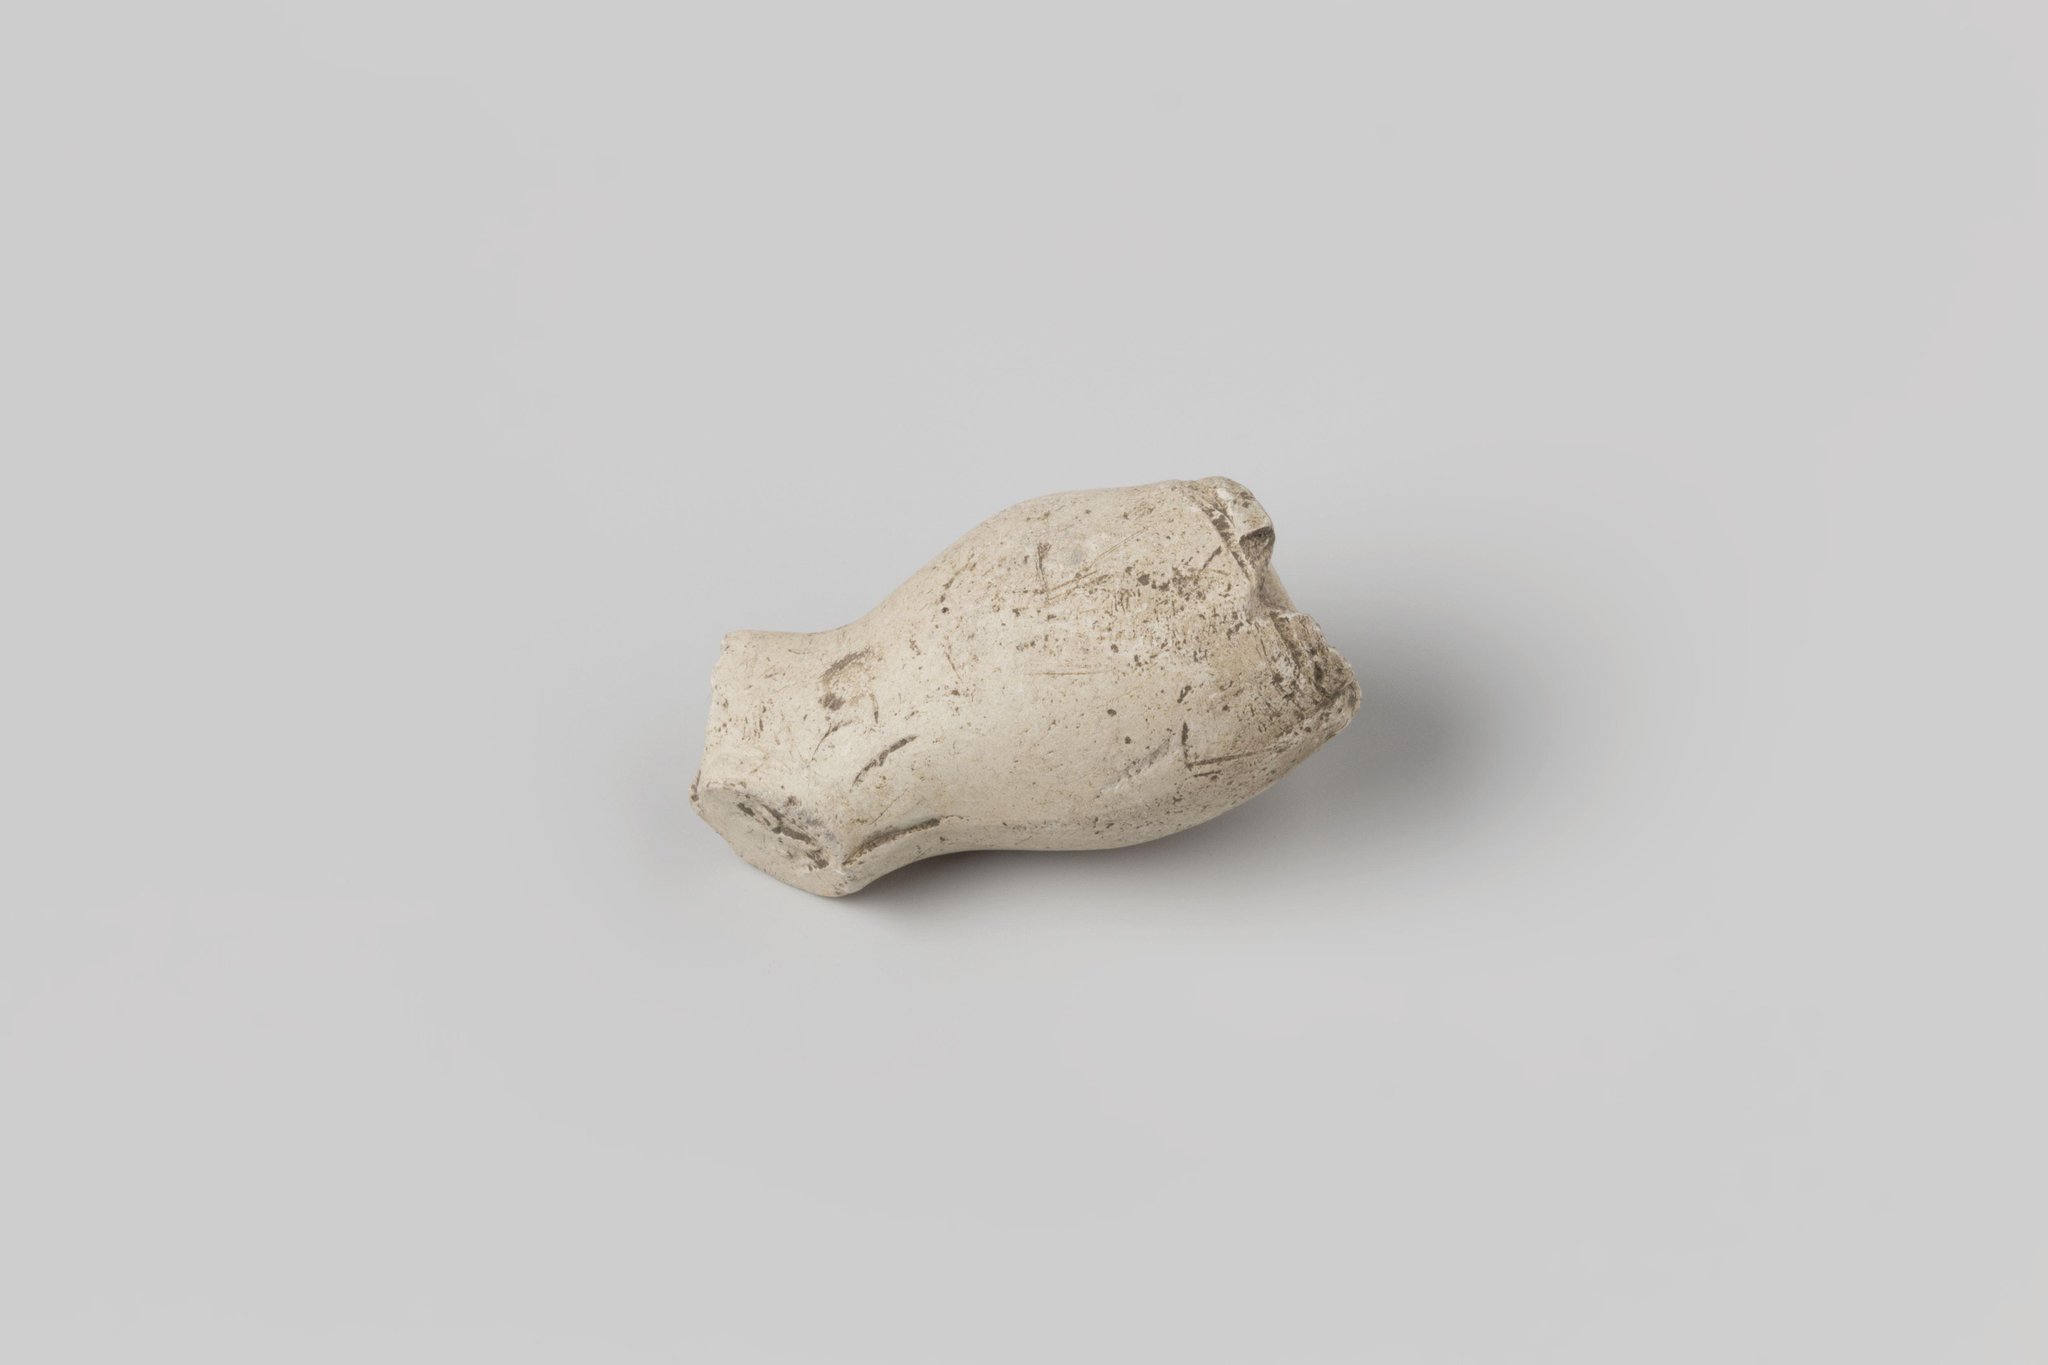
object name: pipe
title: Pijpenkop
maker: Anonymous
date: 1630-1650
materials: clay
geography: netherlands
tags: the hague, rotterdam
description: Pijpenkop. Van de opgravingen op de Hofstede Arentsburg 1827-1831 onder toezicht van Professor Reuvens.